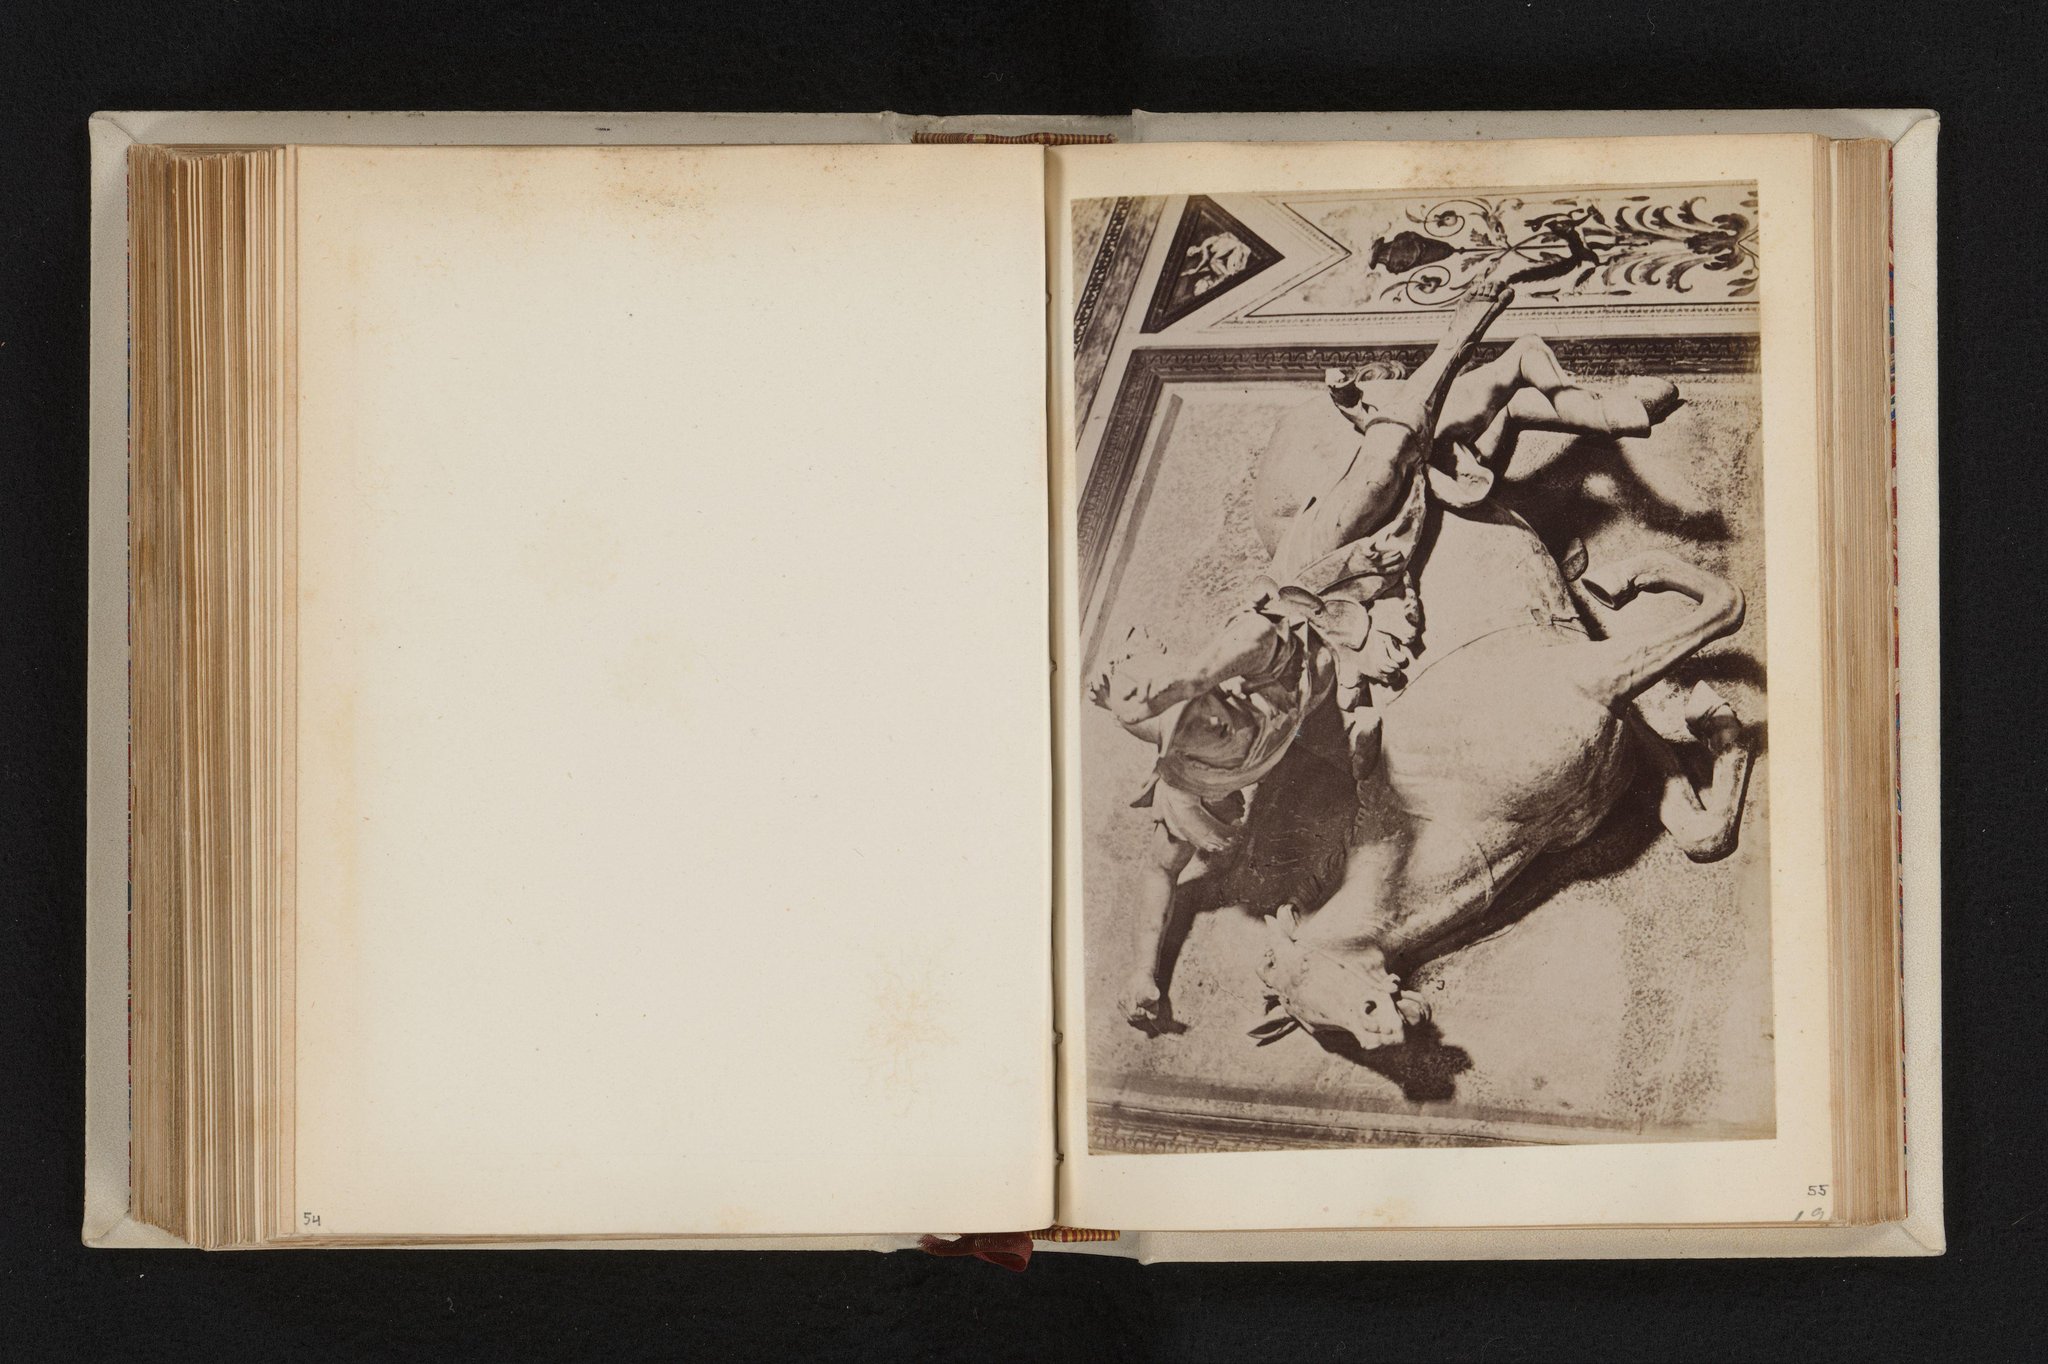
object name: photograph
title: Reliëf van een man die van zijn paard valt in Villa Borghese in Rome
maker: Anonymous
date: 1850-1860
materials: photographic support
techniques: albumen print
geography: villa borghese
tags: piece of sculpture, reproduction of a piece of sculpture